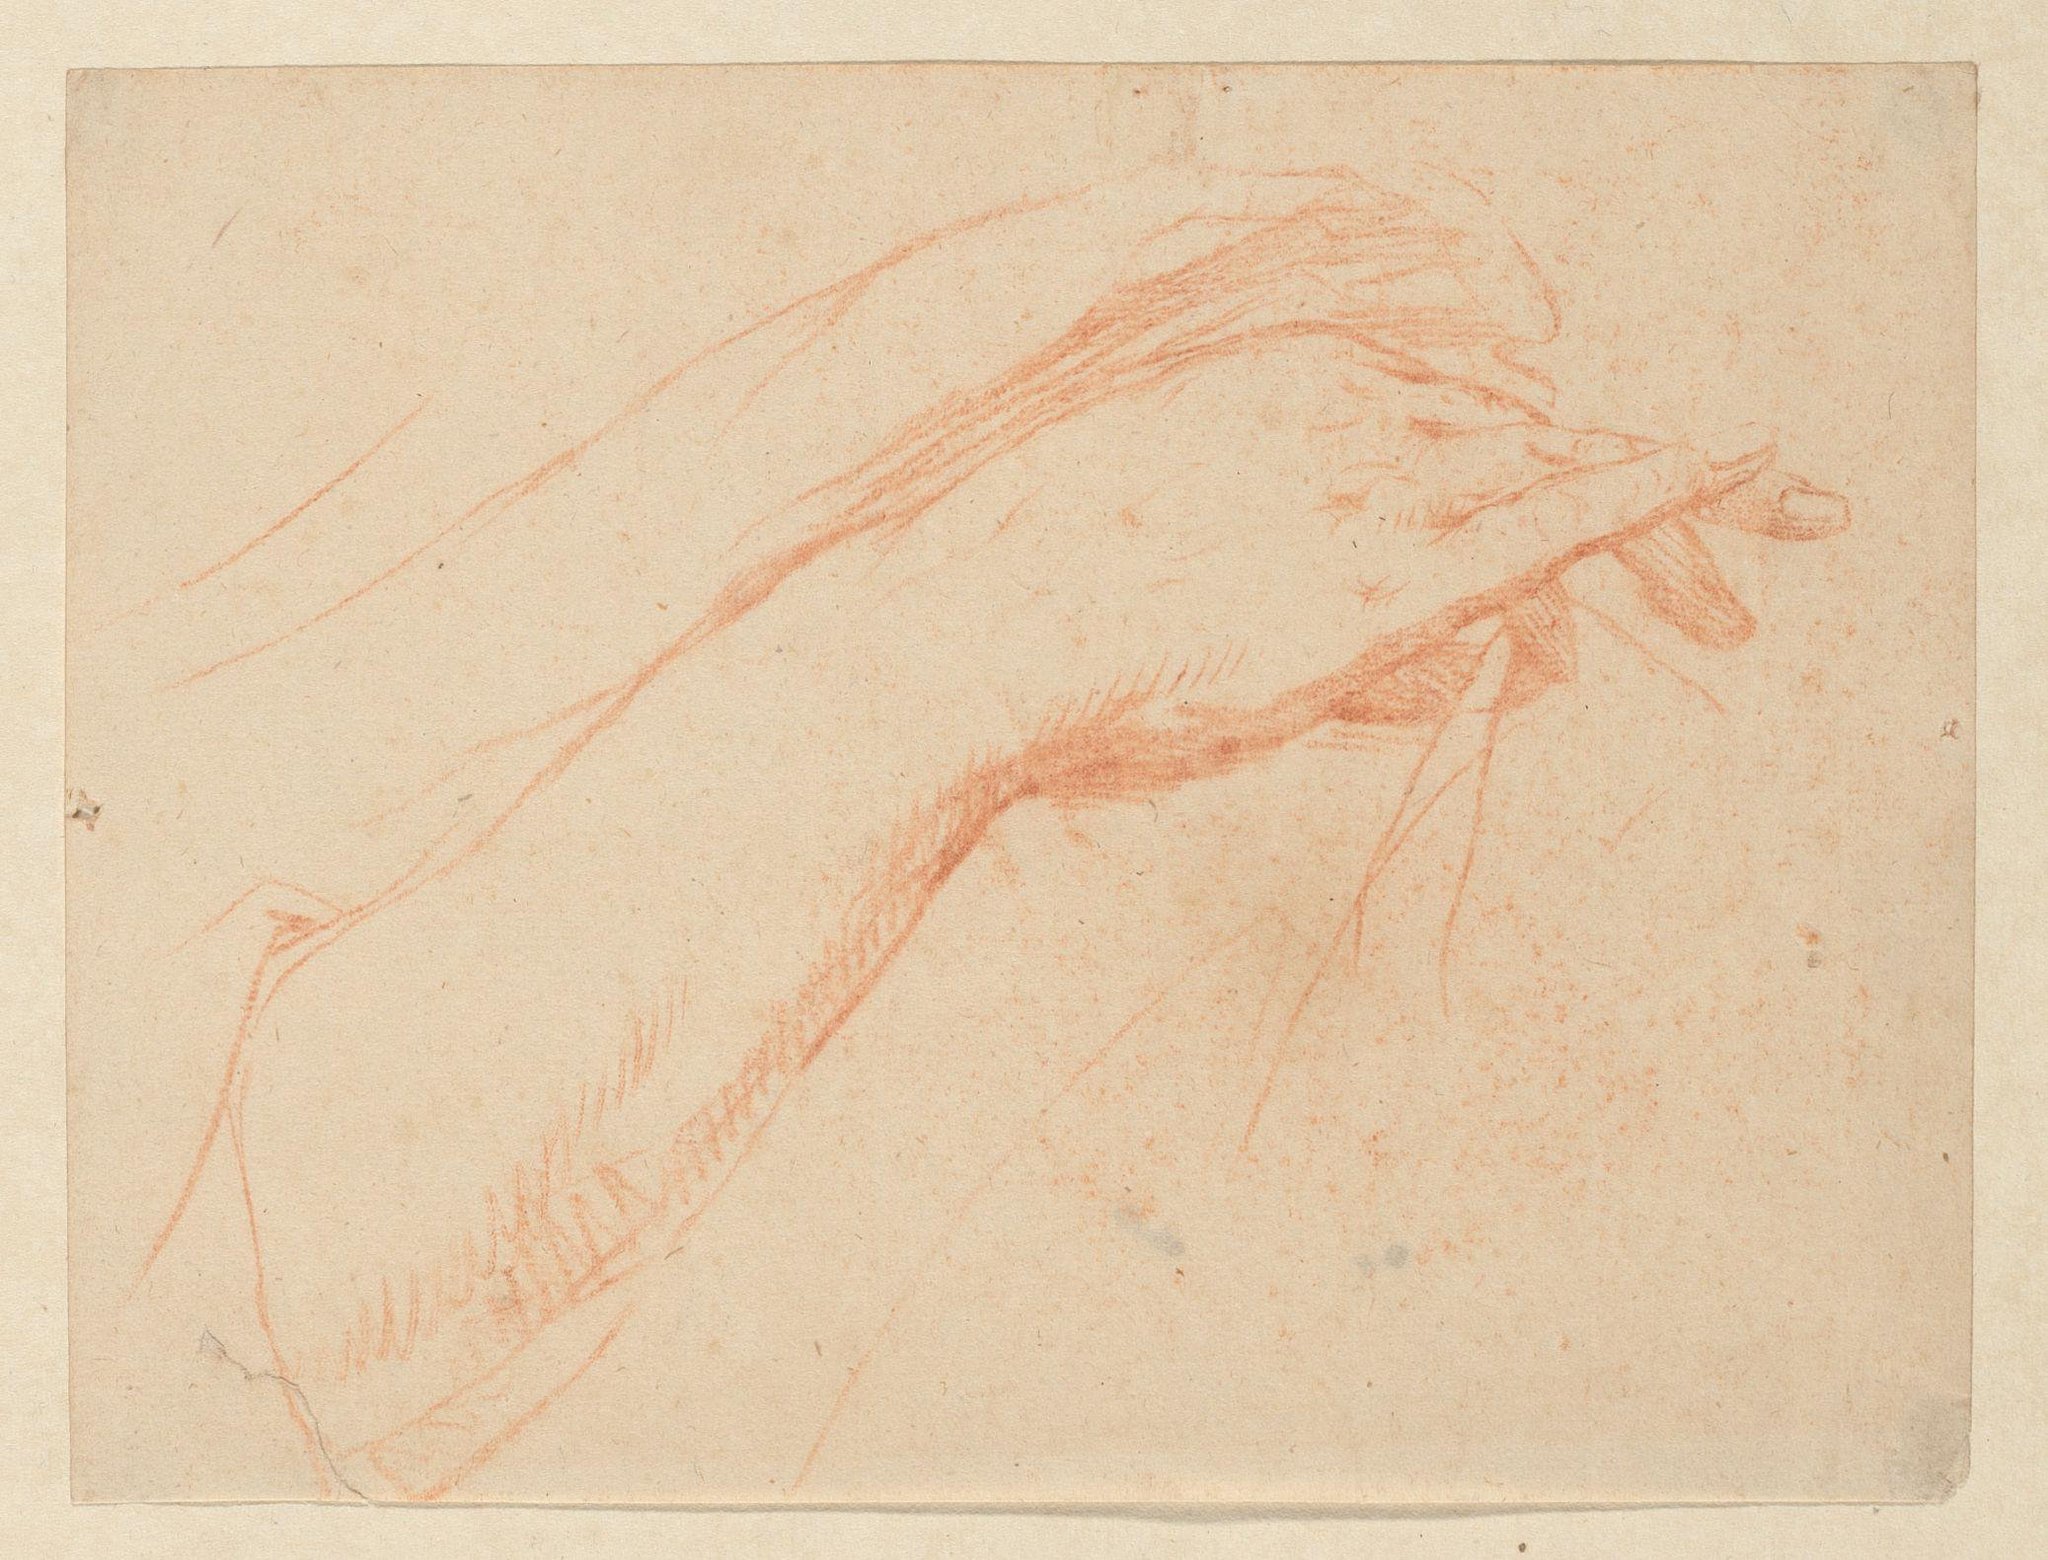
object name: drawing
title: Studie van een hand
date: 1649-1723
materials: chalk, paper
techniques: printmaking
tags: postures and gestures of hand and fingers